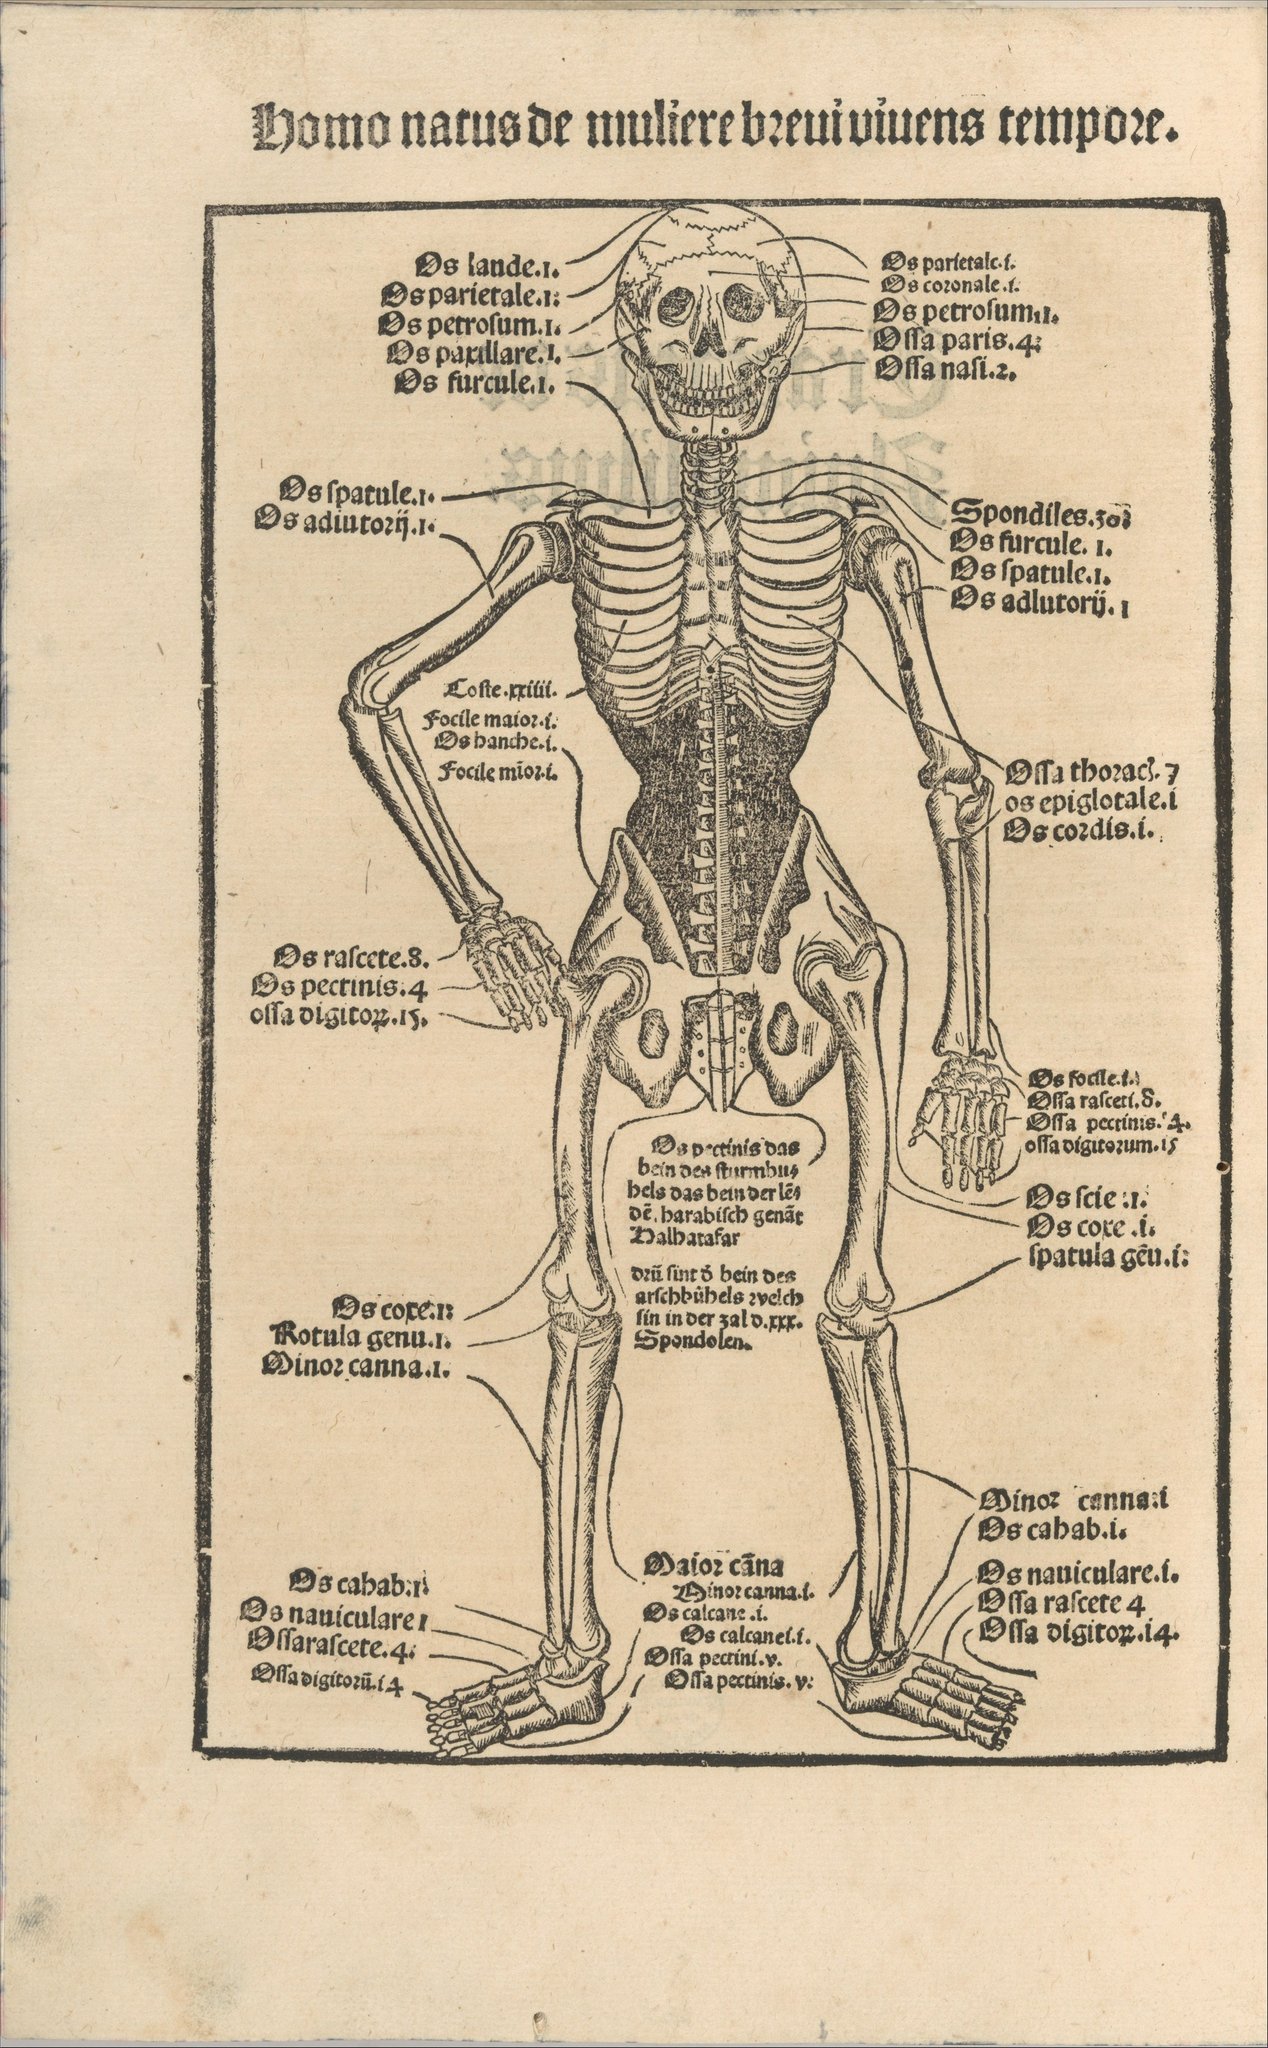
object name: book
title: Ortus Sanitatis/ De herbis et plantis/ De Animalibus & reptilibus ...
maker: johann prüss the elder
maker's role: printer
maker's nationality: german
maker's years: 1480-1510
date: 1497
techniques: woodcut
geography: germany